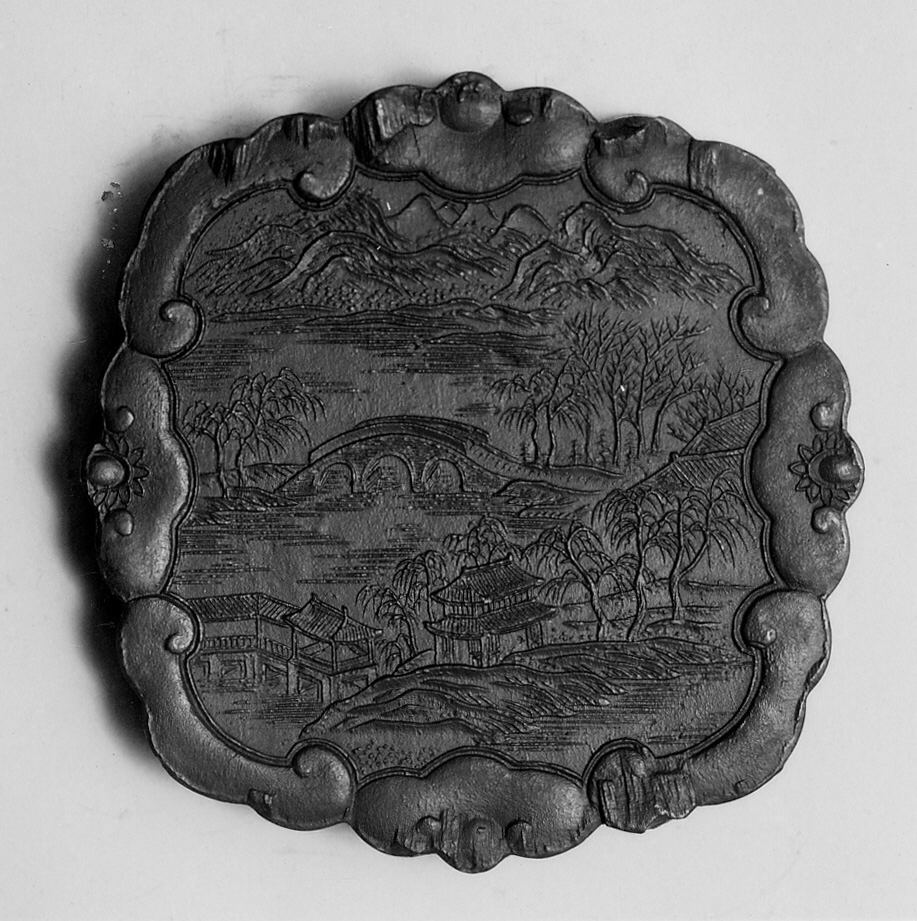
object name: ink tablet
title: The Bounteous and Fertile Garden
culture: chinese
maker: jian guzhai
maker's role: artist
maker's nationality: chinese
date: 1867-1933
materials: gilt, wood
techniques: bookbinding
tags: bridges,mountains,landscapes